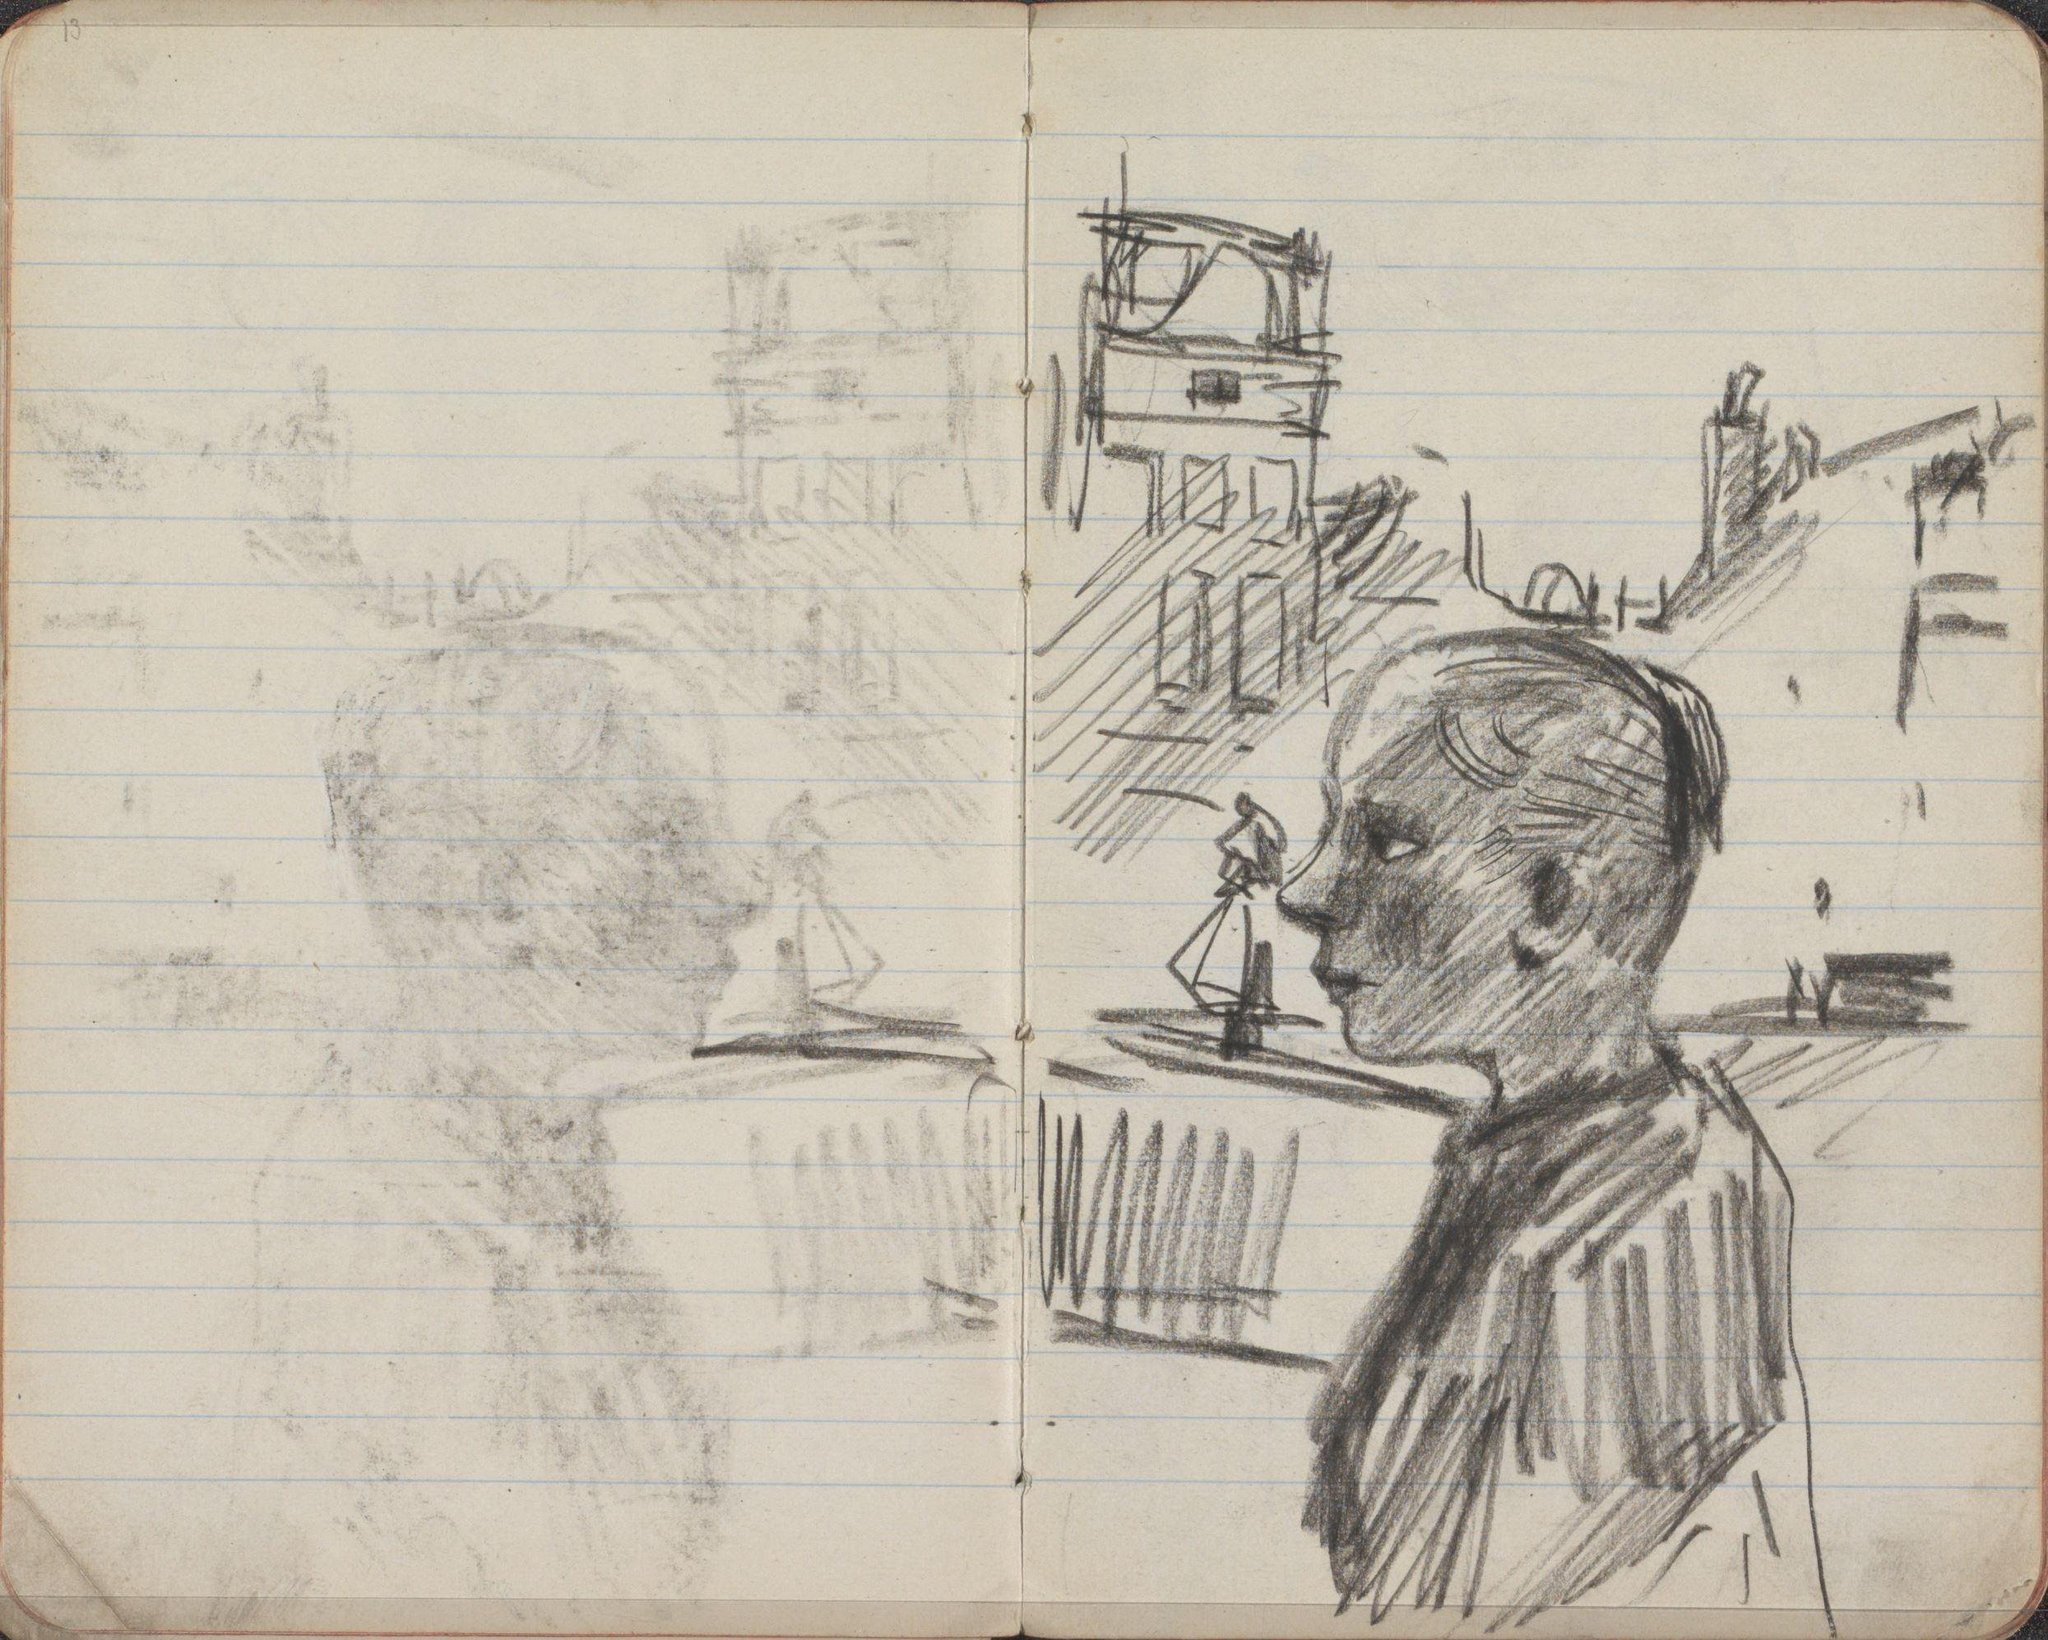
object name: sketchbook leaf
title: Waspit, mogelijk op de Lauriergracht te Amsterdam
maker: george hendrik breitner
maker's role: draughtsman, painter, print maker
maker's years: 1857-1923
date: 1893-1898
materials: chalk, paper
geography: amsterdam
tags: adolescent, young woman, maiden, canals, waters (in city) (+ city(-scape) with figures, staffage), working class, labourers - aa - women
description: Pagina 13 en pagina 14 uit een schetsboek met 38 bladen.